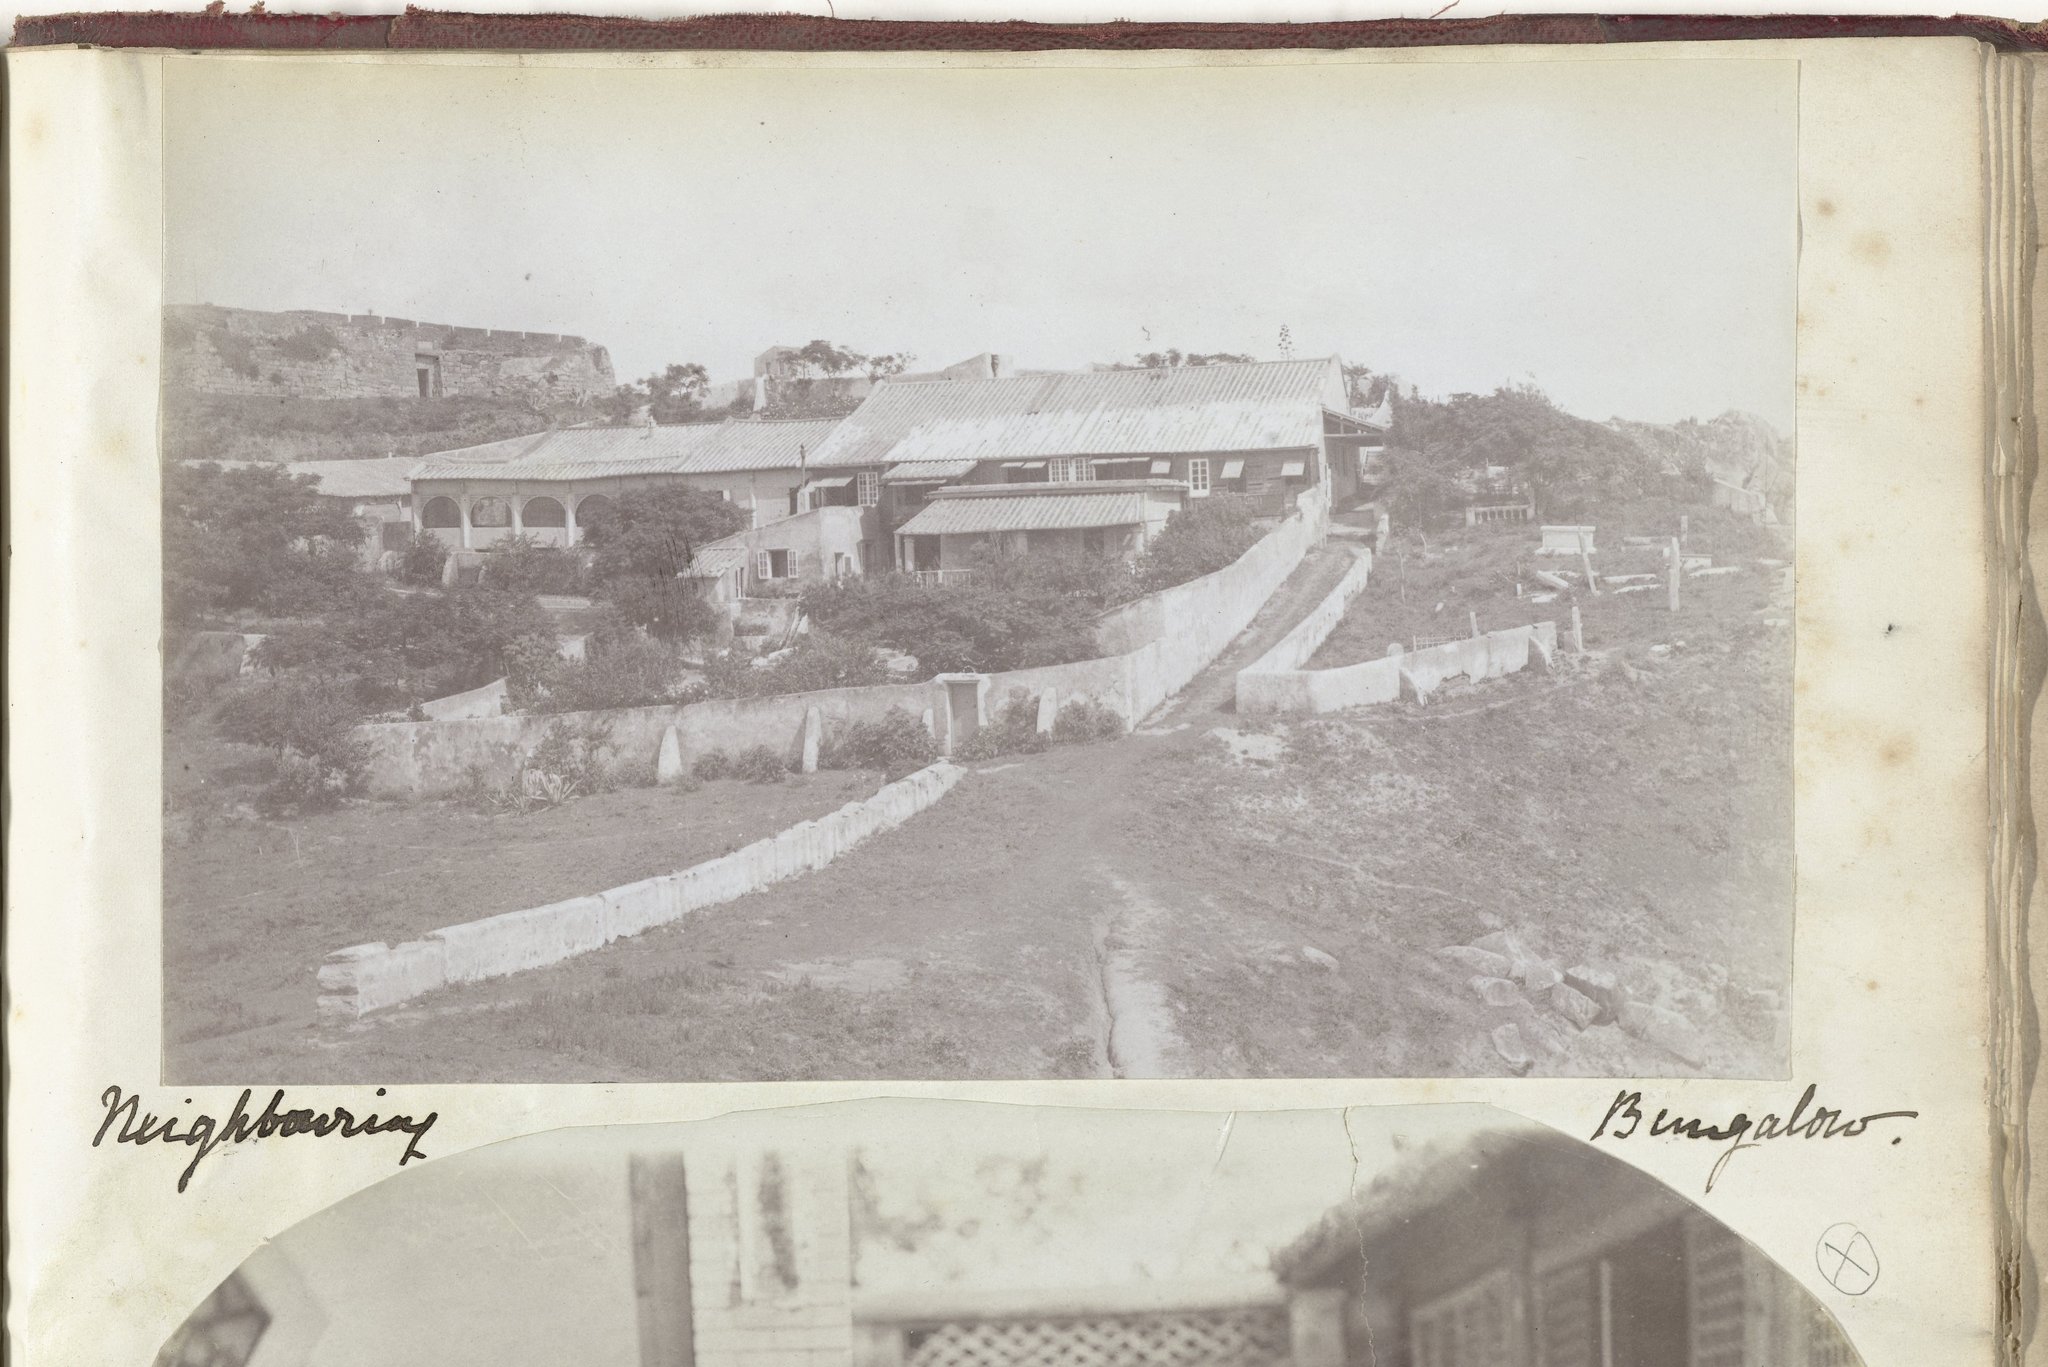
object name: album leaf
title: Bungalow op een heuvel, Shantou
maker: Anonymous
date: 1879-1890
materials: paper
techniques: albumen print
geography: shantou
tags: rural housing, e.g. country-house, villa, cottage, shantou